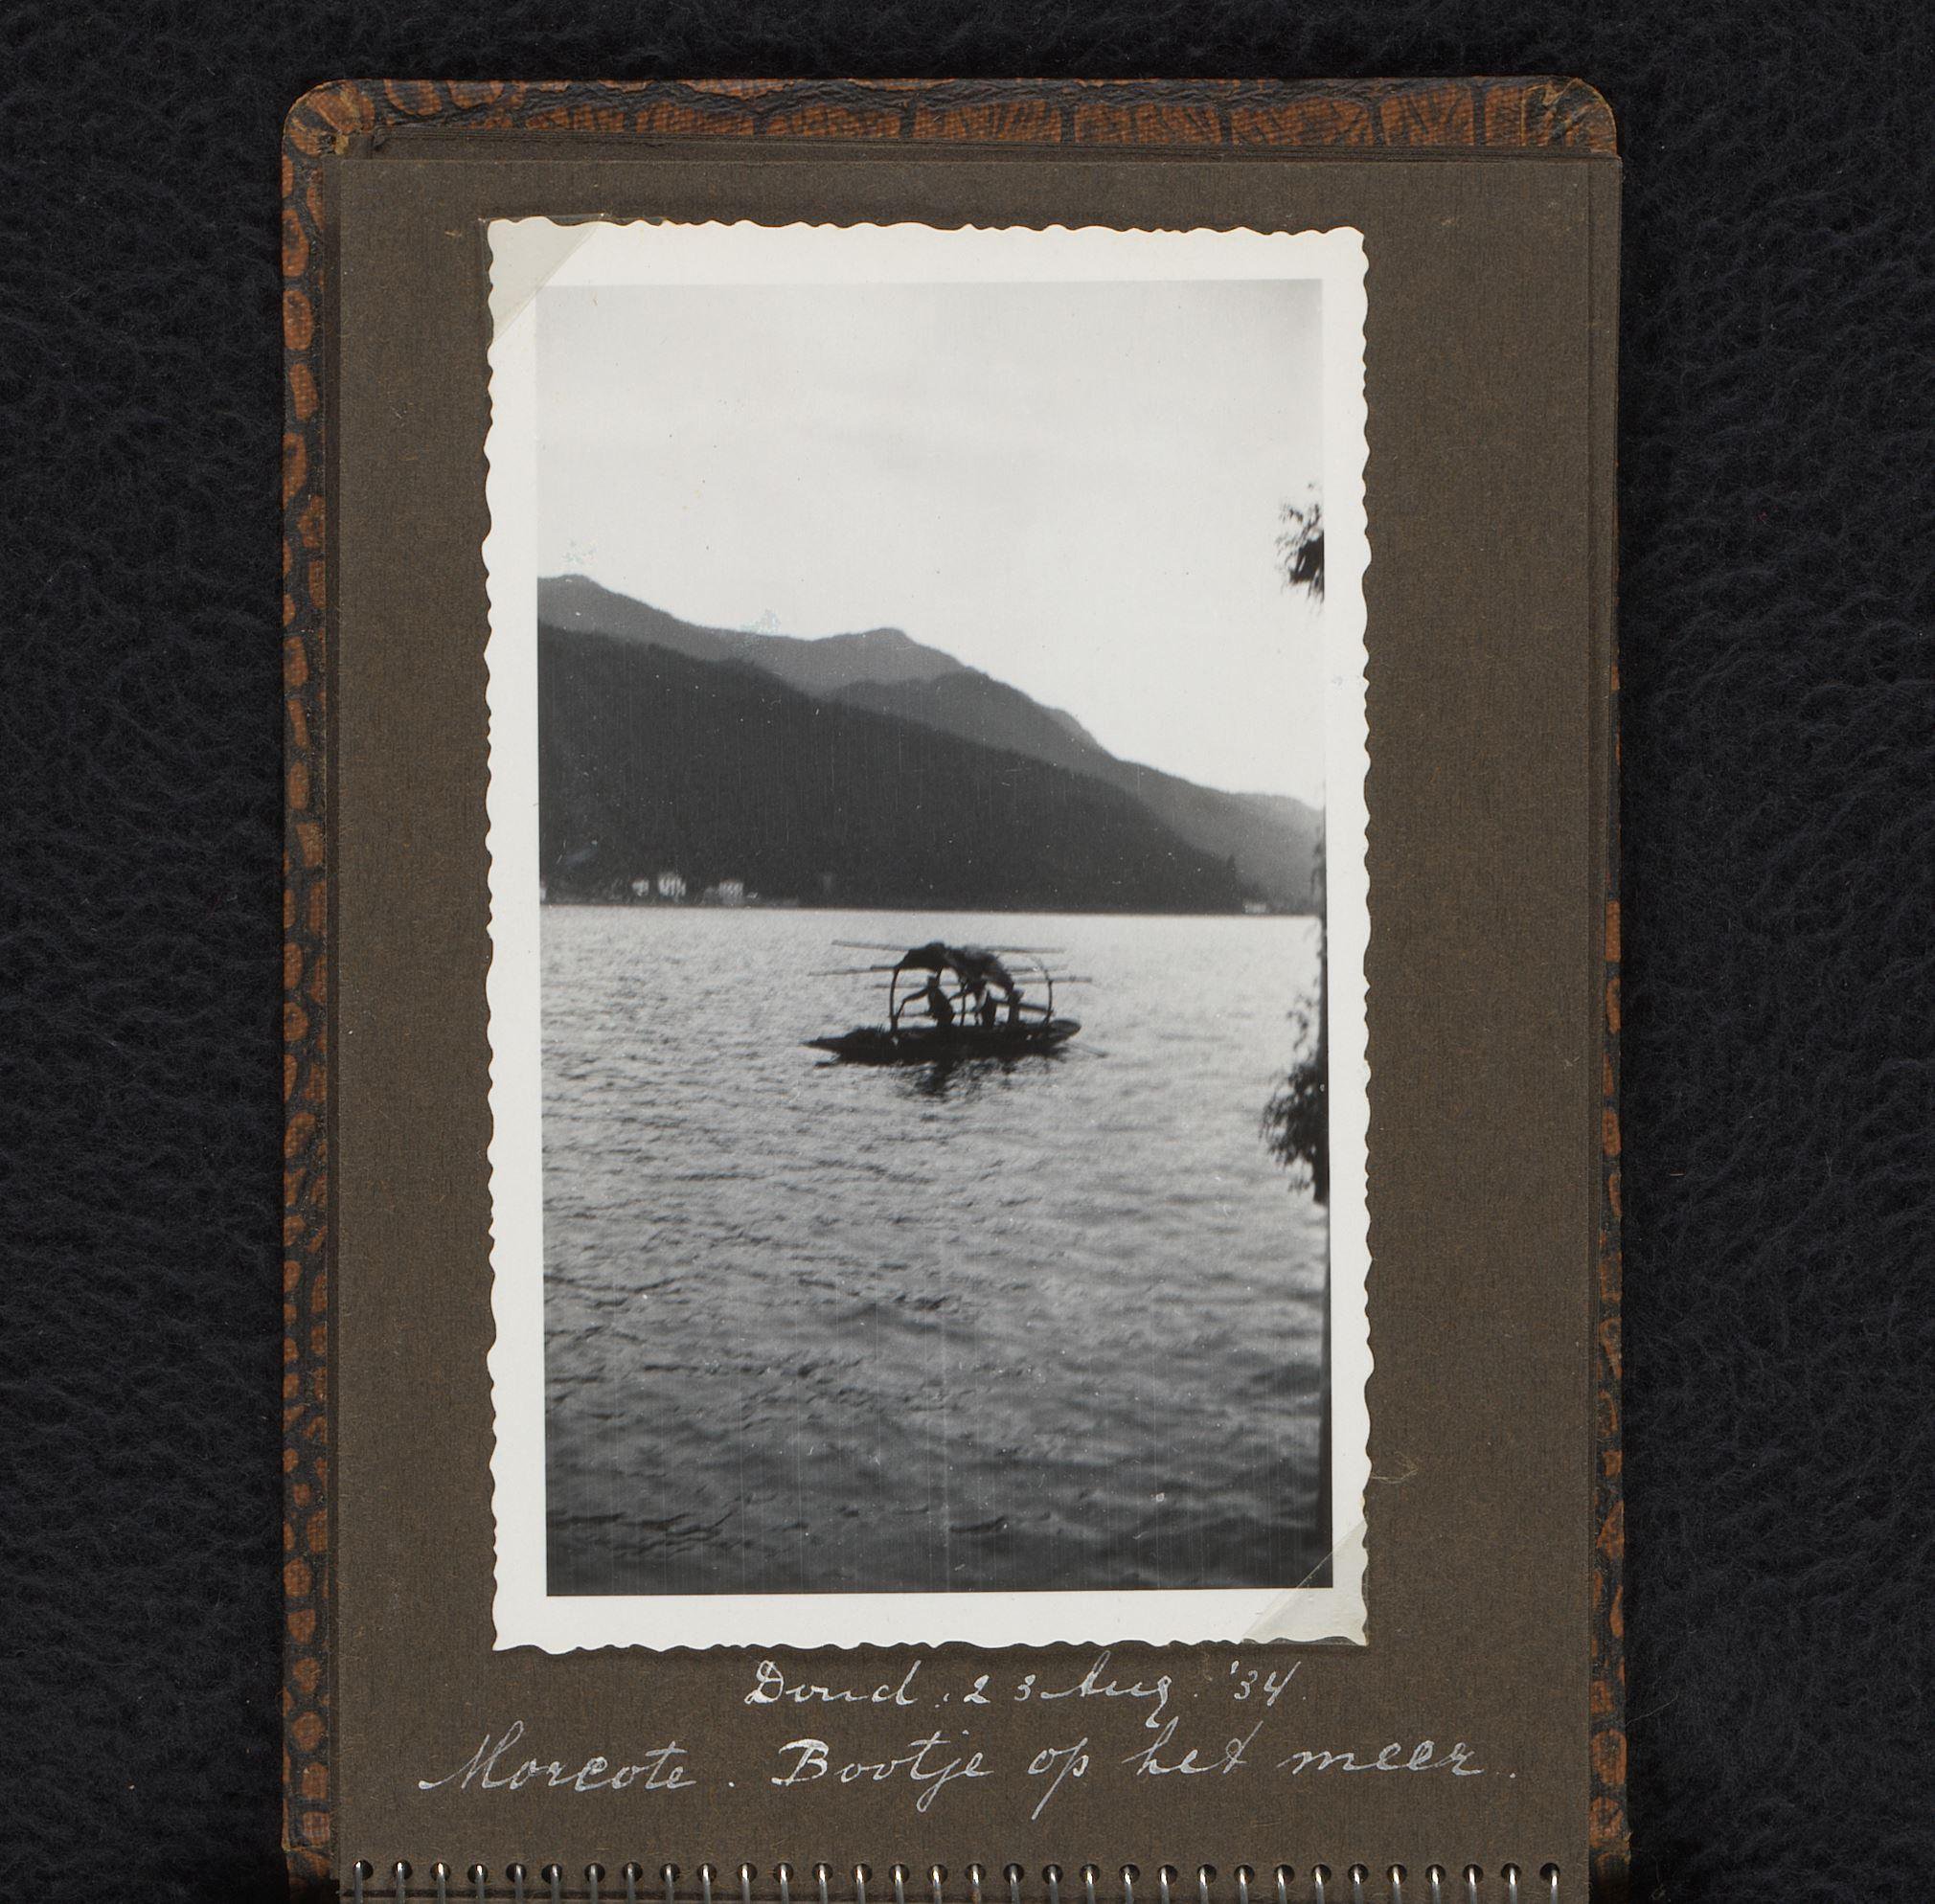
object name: photograph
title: Boot op het meer van Lugano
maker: Anonymous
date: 1934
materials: paper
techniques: gelatin silver print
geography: morcote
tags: rowing-boat, canoe, etc., lake